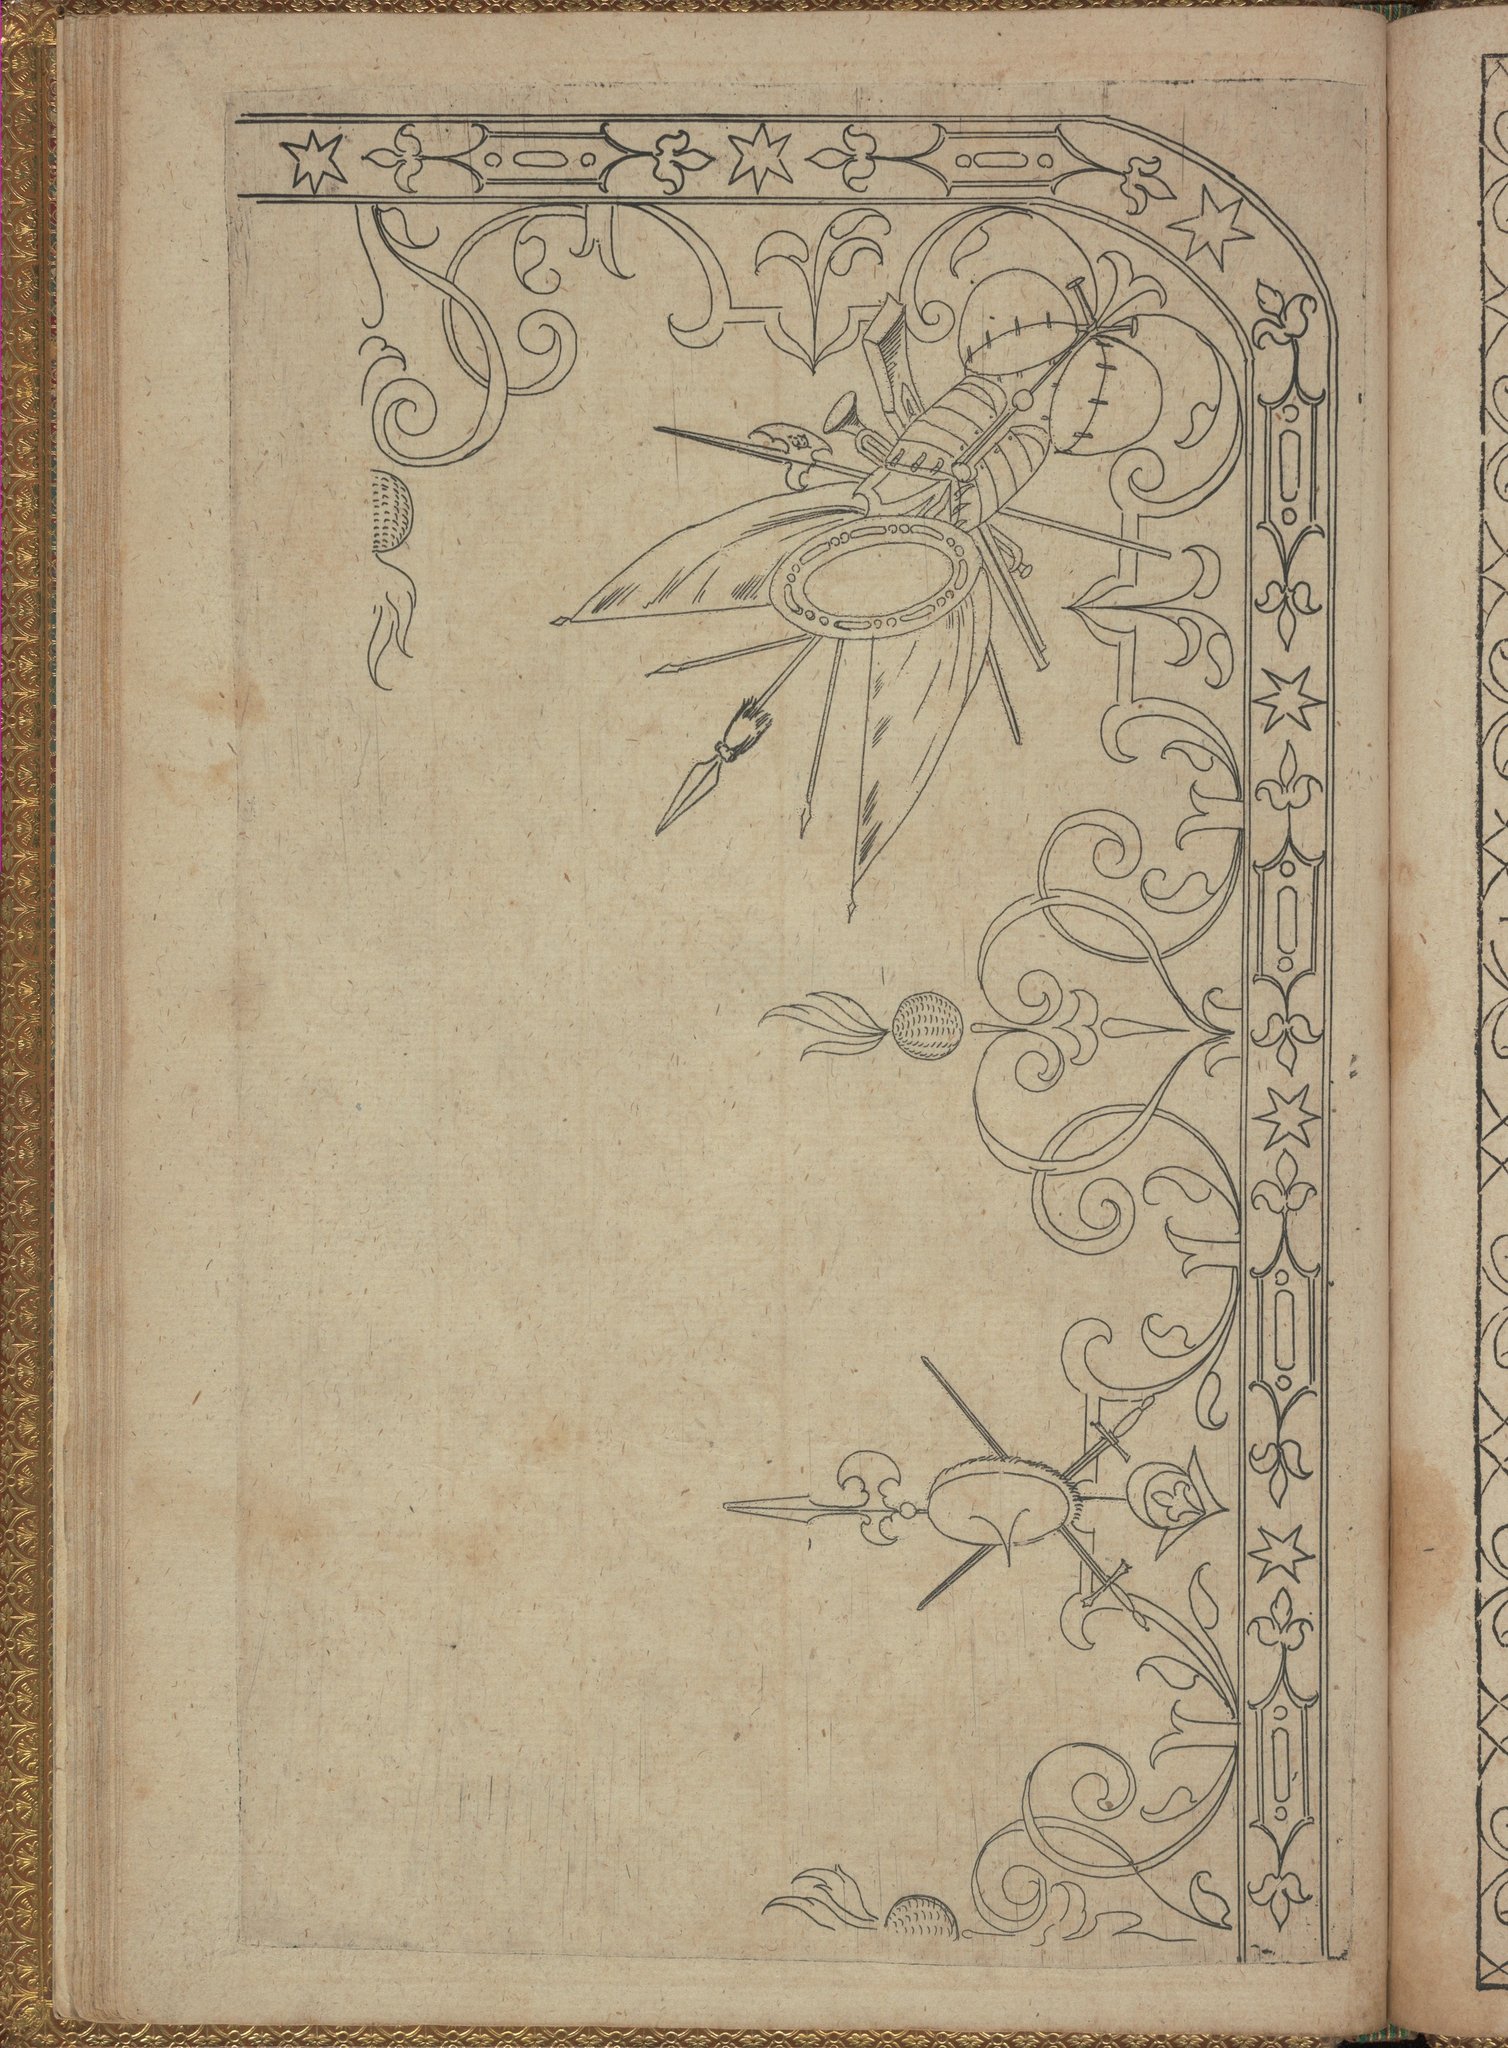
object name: book print ornament architecture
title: New Modelbüch (Page 28r)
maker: andreas bretschneider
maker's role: designer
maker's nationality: german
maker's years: 1573-1645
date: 1615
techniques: woodcut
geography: germany